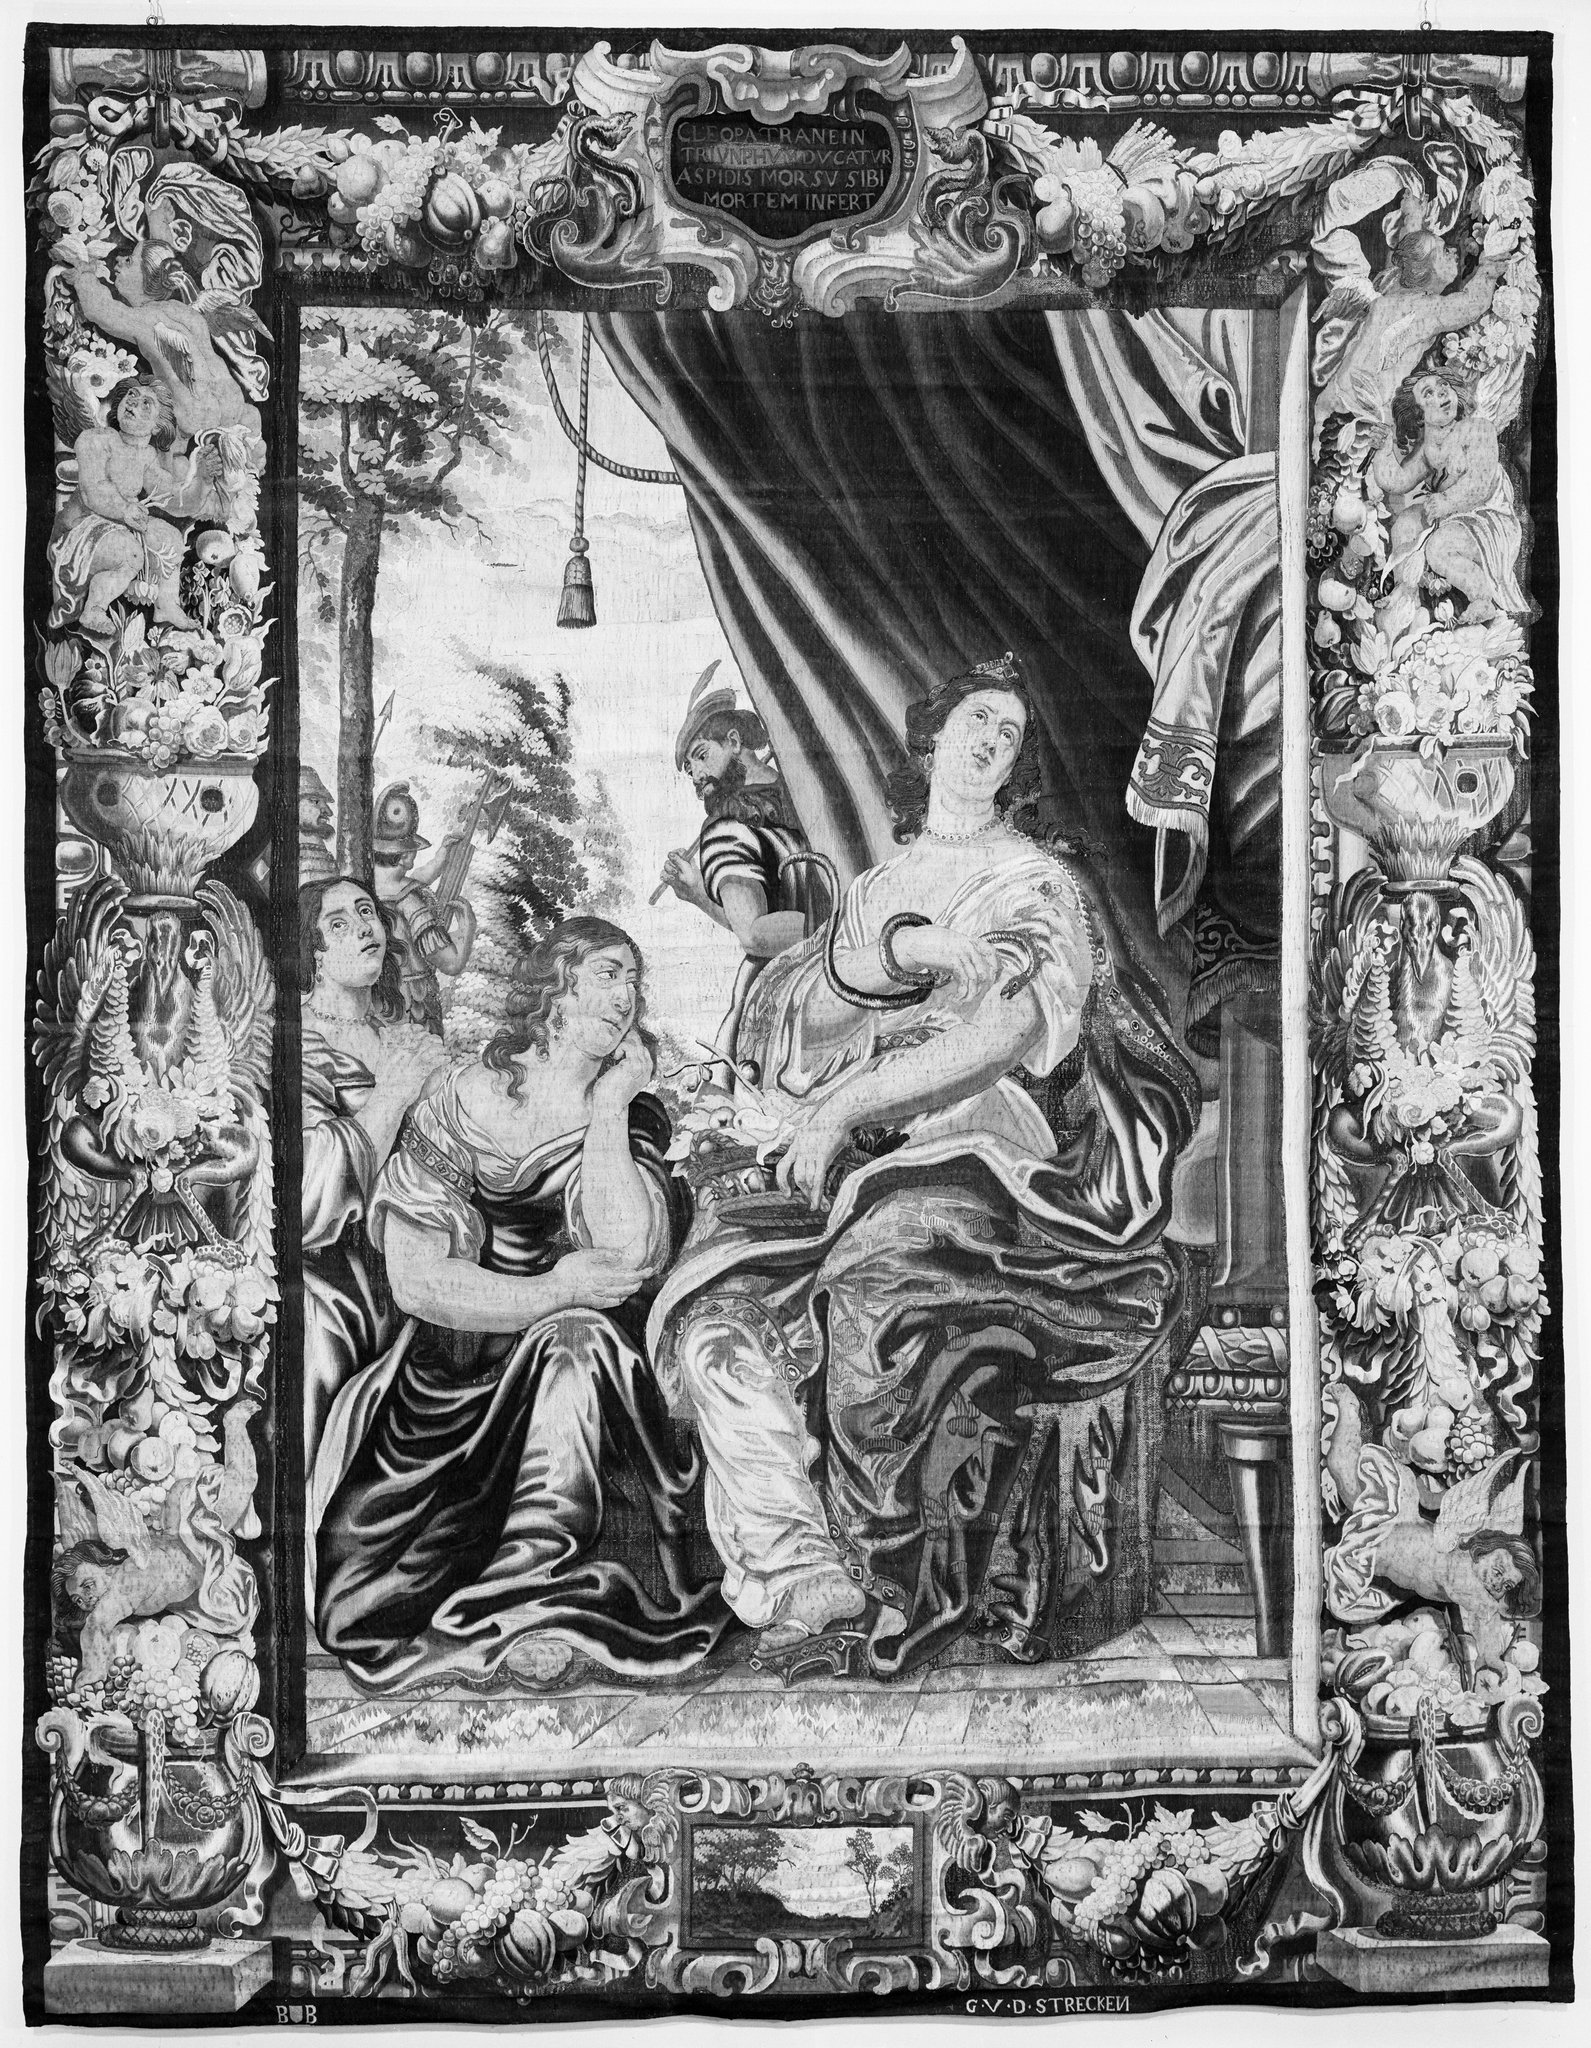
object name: tapestry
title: The Death of Cleopatra from a set of The Story of Antony and Cleopatra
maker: justus van egmont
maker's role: designer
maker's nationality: flemish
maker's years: 1601-1674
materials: silk, silver, silver gilt, thread, wool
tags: cleopatra,men,women,snakes